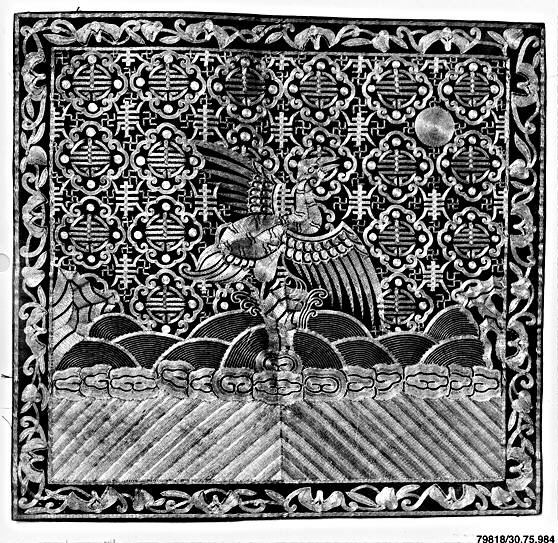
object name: rank badge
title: Rank Badge with Wild Goose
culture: chinese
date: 1767-1833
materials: metal thread, silk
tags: bats,geese